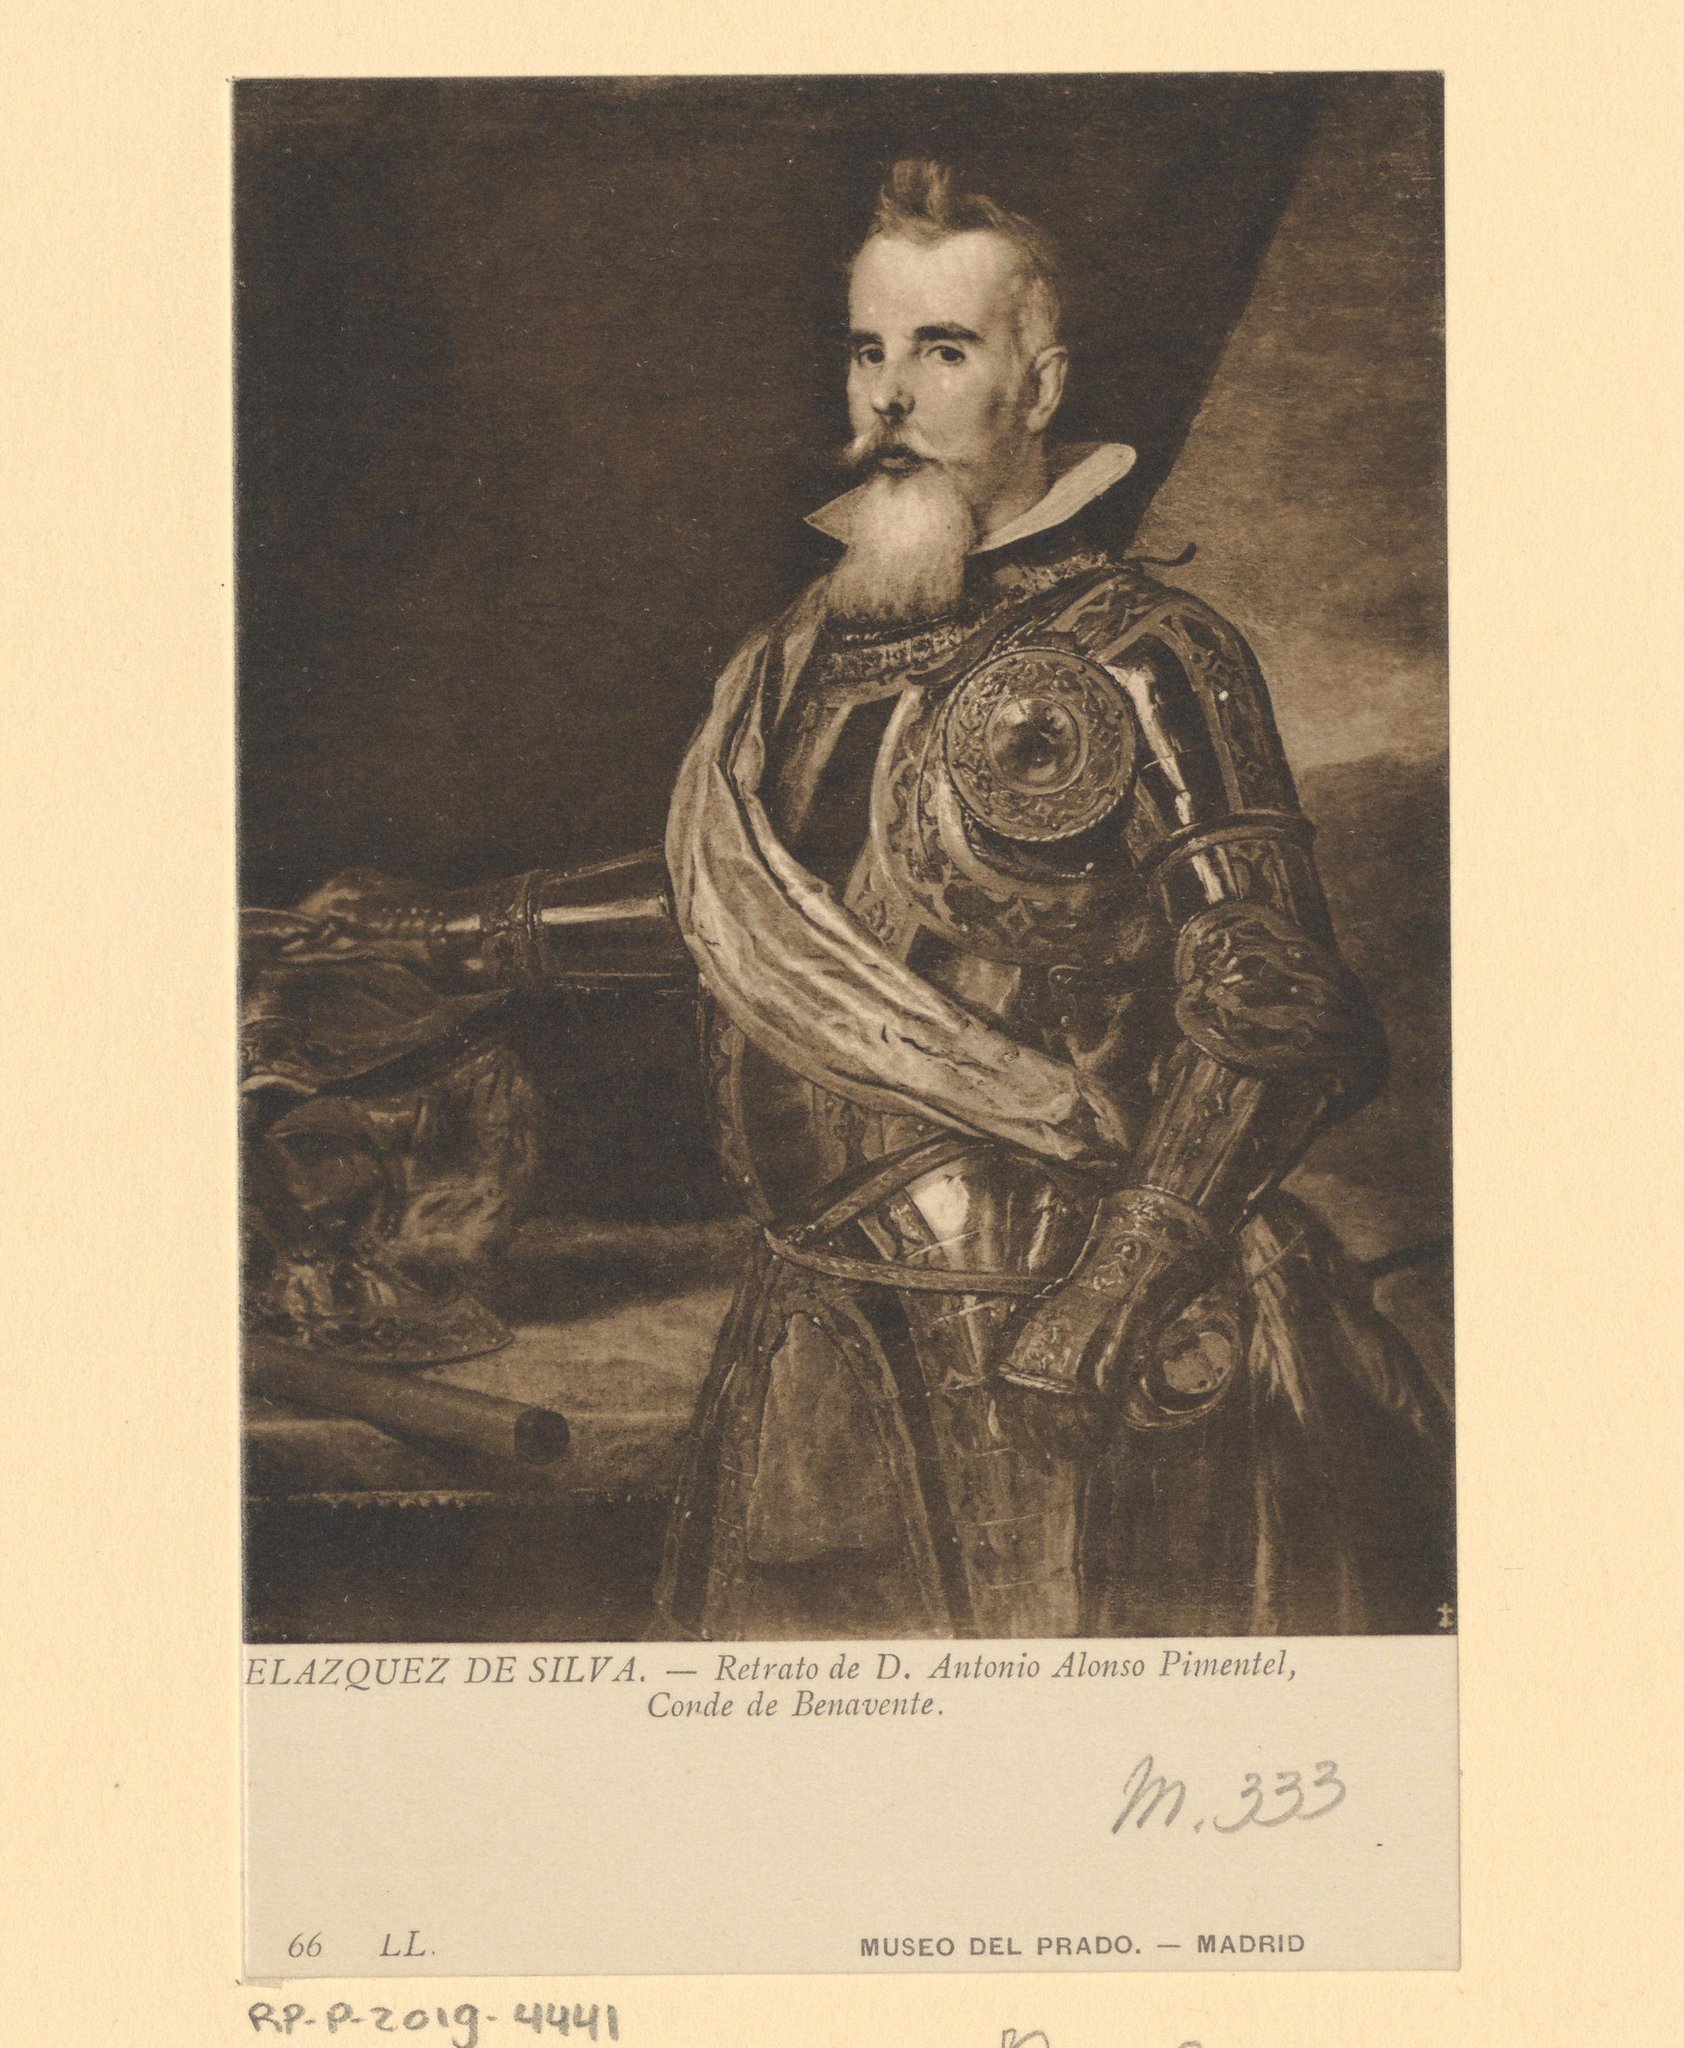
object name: photomechanical print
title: Portret van Juan Francisco Pimentel, hertog van Benavente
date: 1900-1949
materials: paper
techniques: photoaquatint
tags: armour, historical persons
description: Prentbriefkaart van het Museo Nacional del Prado te Madrid.